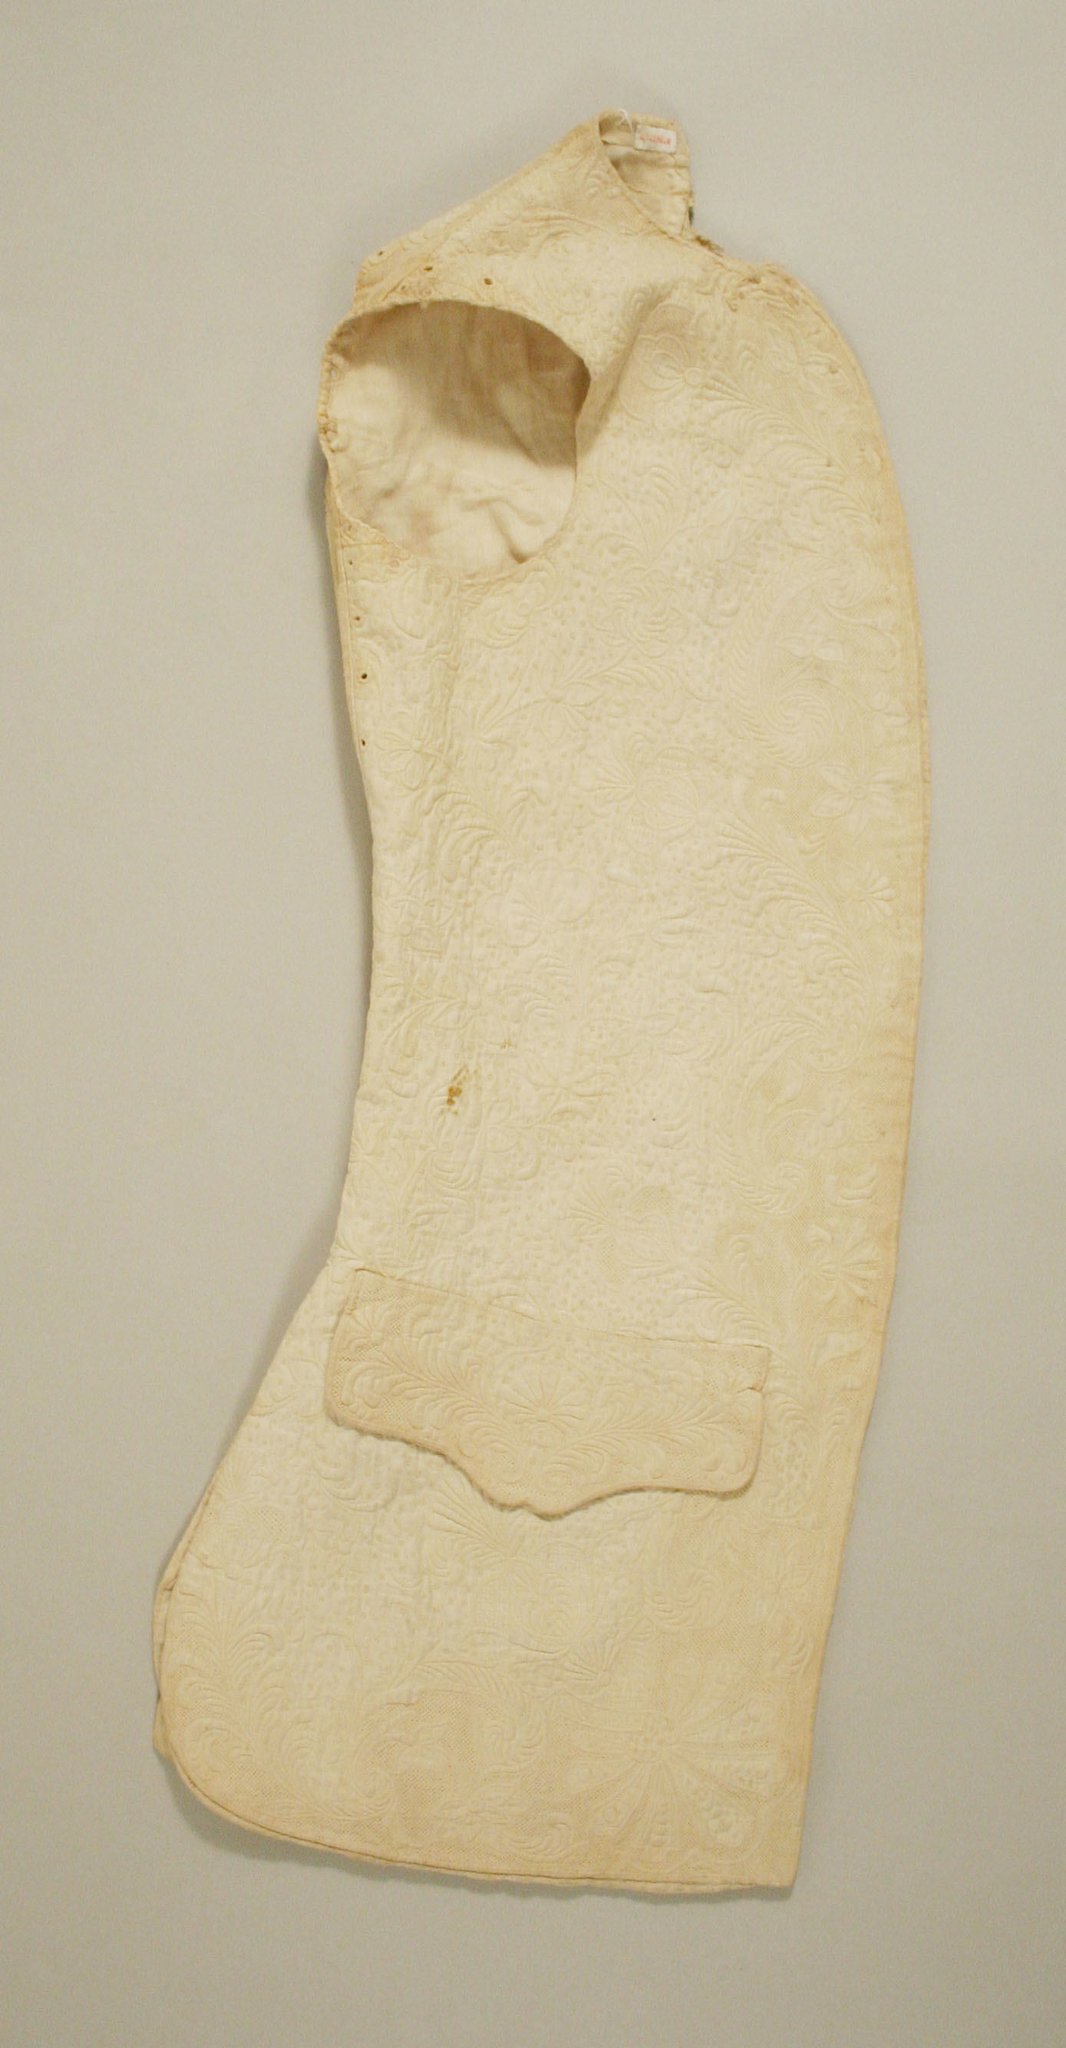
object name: waistcoat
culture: french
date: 1701-1800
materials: linen